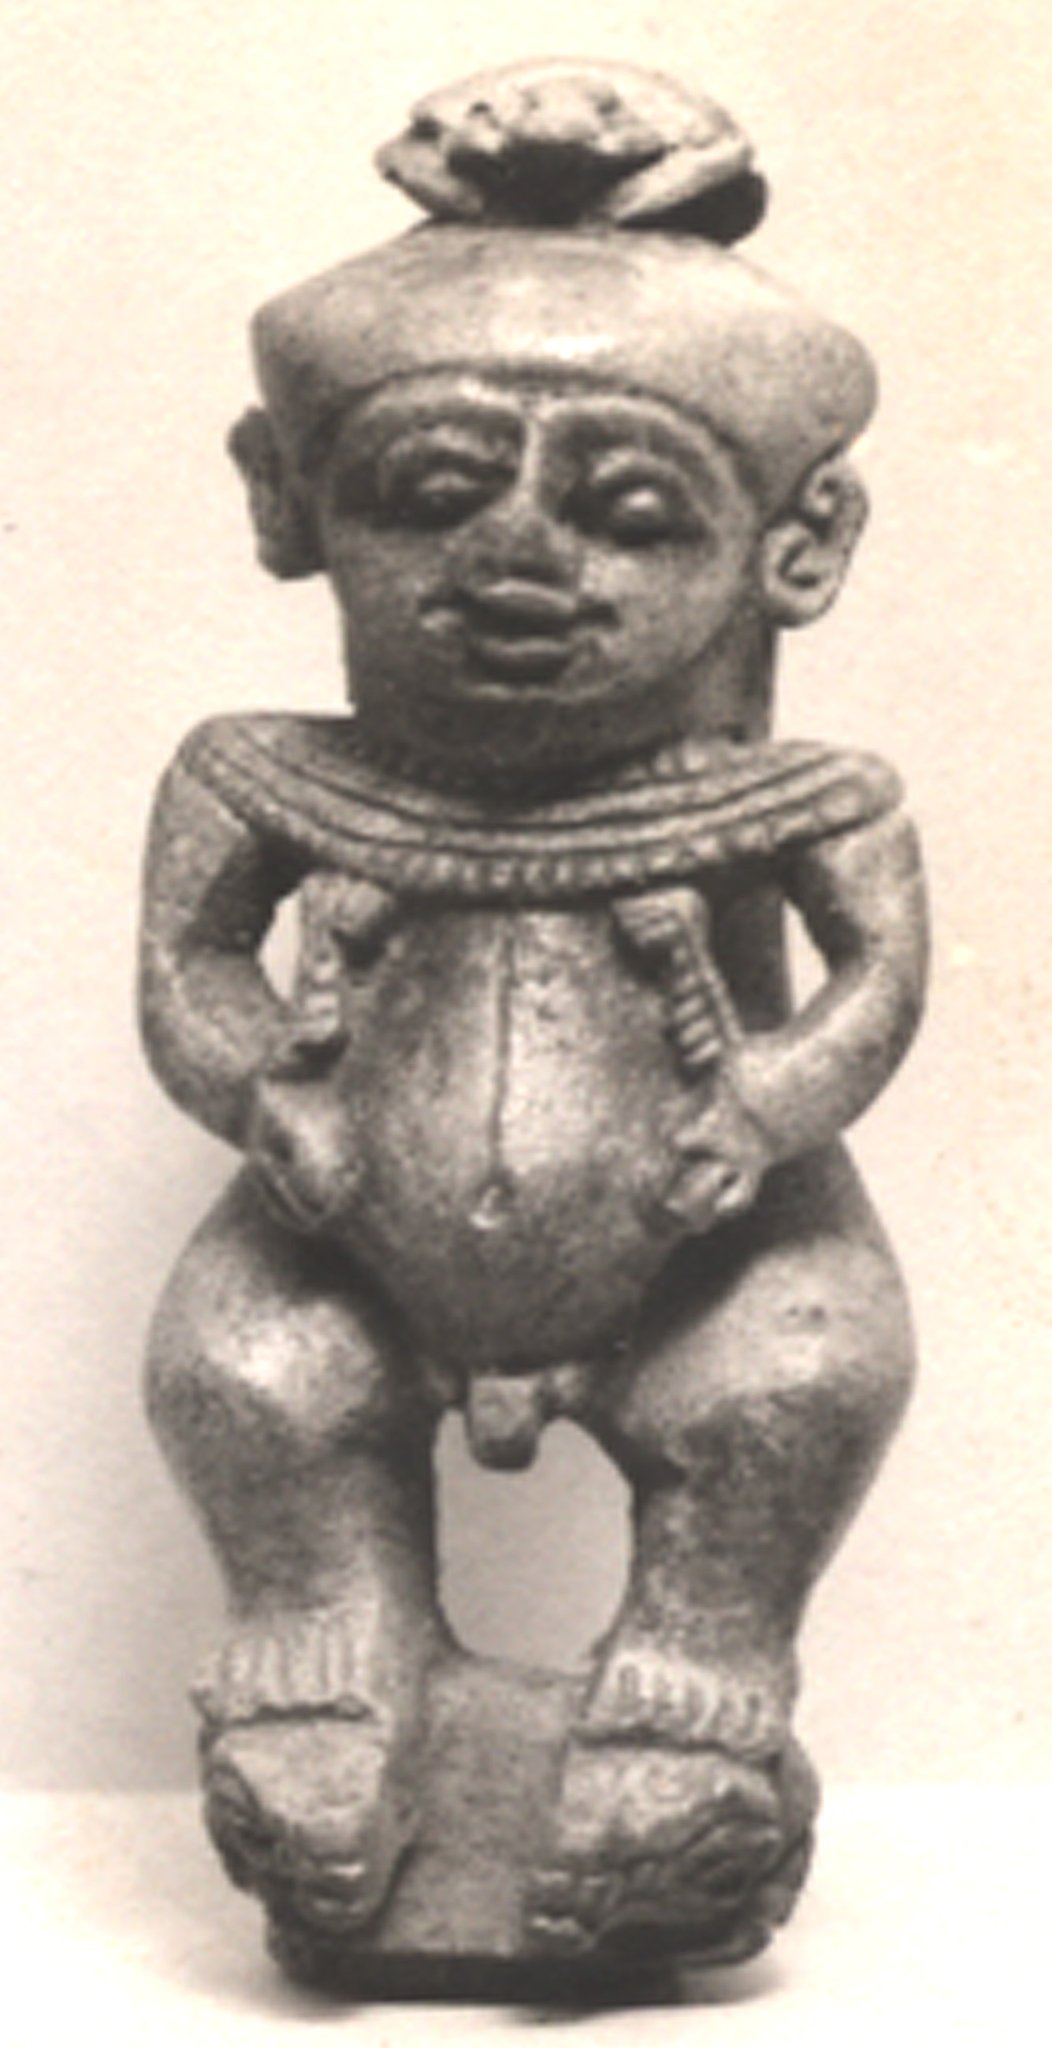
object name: amulet, ptaikos on crocodile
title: Amulet of Ptaikos on the crocodiles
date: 712-343 BCE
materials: faience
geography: egypt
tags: men